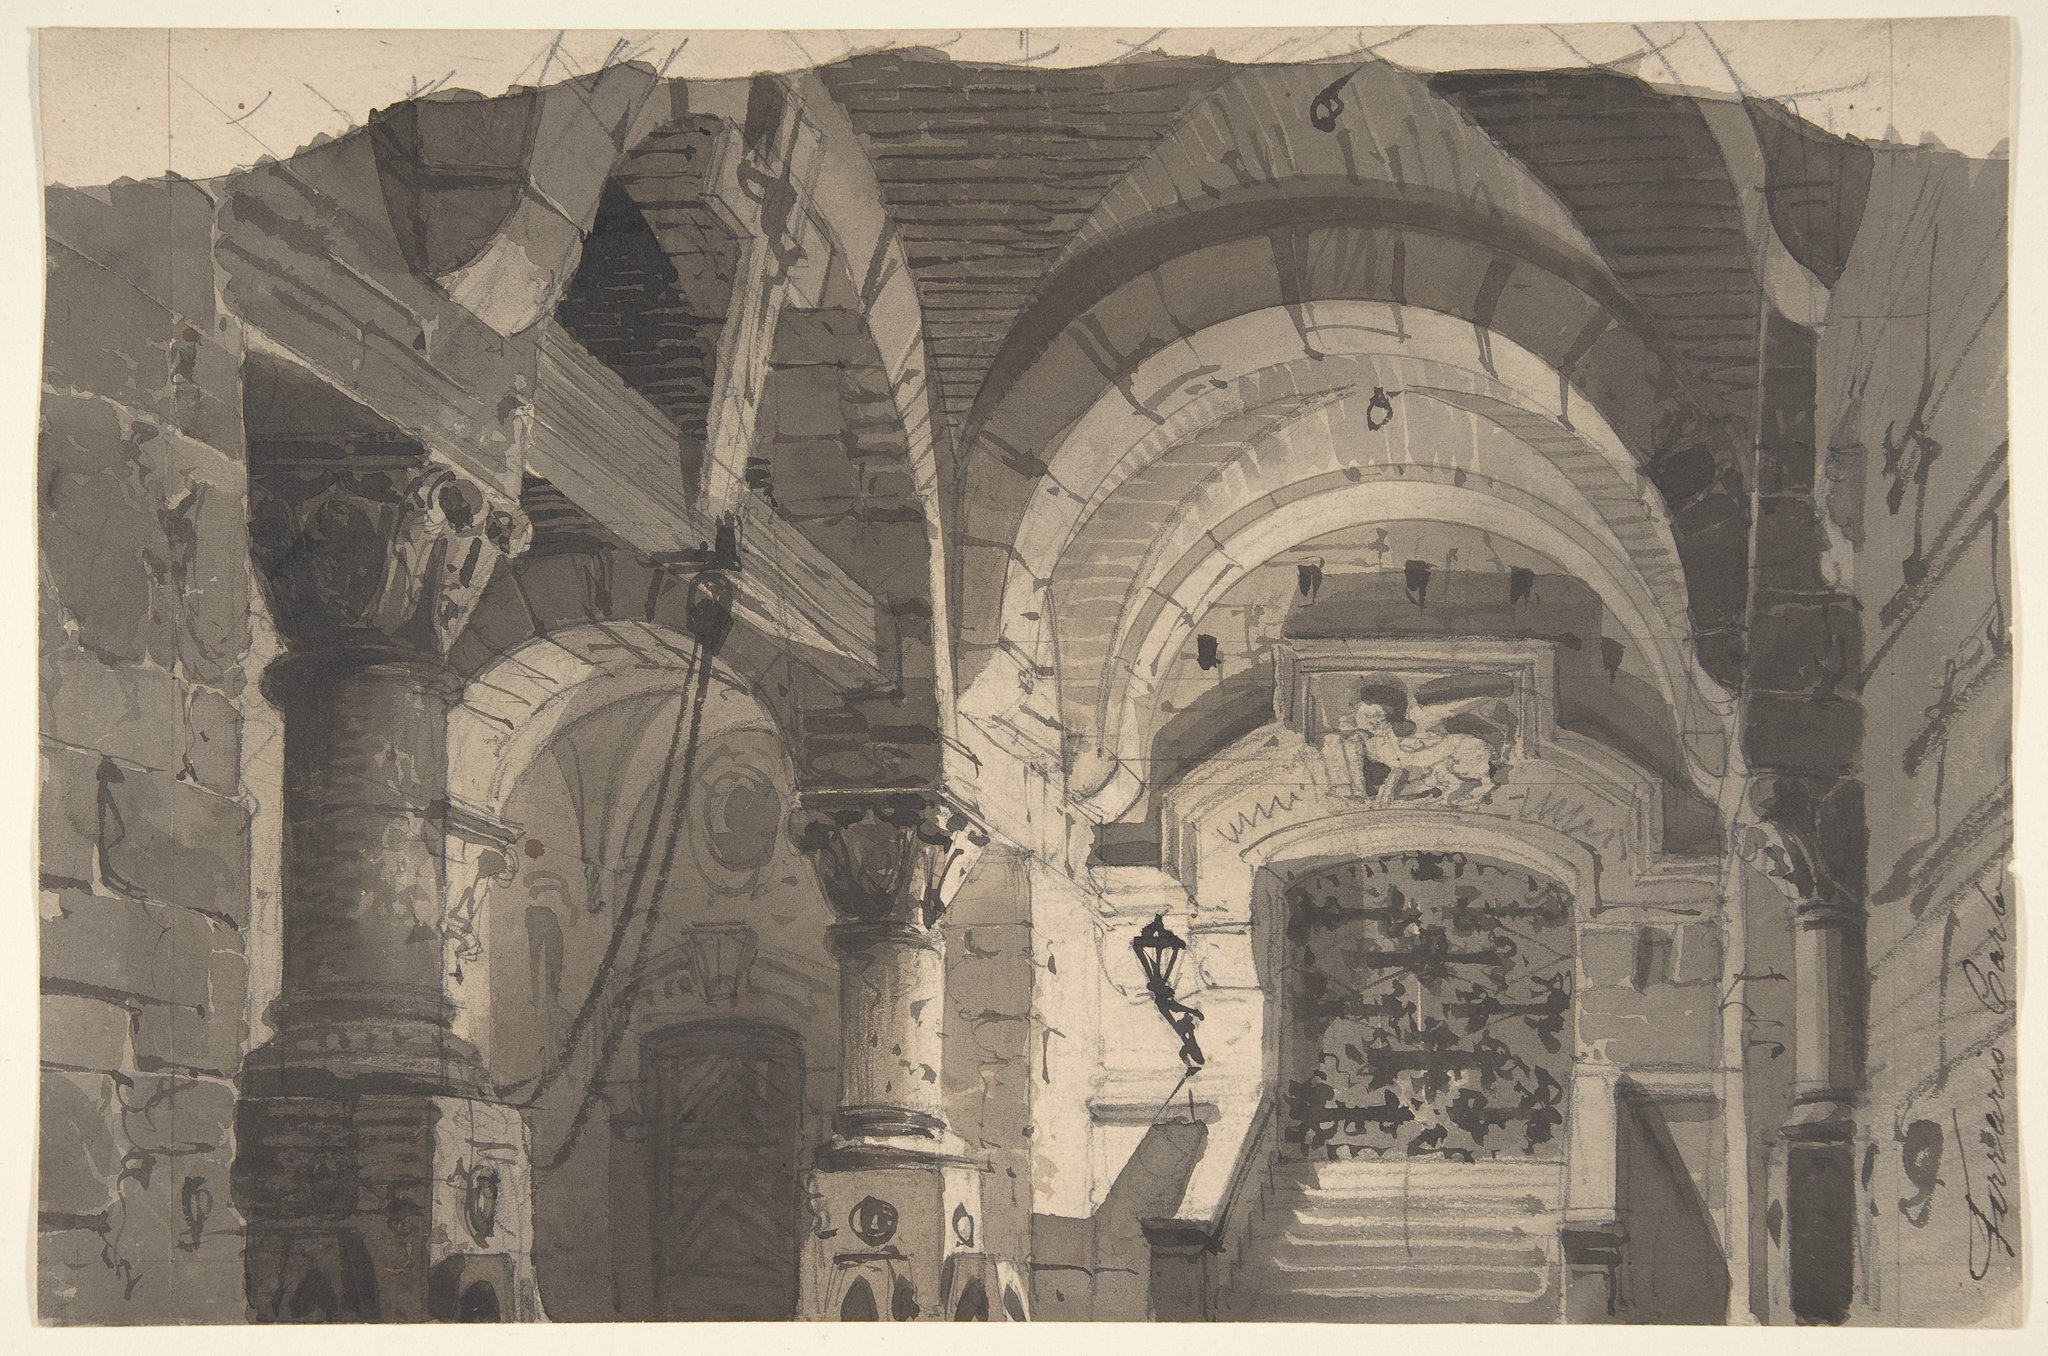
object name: drawing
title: Design for a Stage Set of a Crypt (for the Opera 'La Morosina' ?)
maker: carlo ferrario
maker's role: artist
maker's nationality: italian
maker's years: 1833-1907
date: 1833-1907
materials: graphite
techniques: brush, wash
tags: opera,crypts,stage design